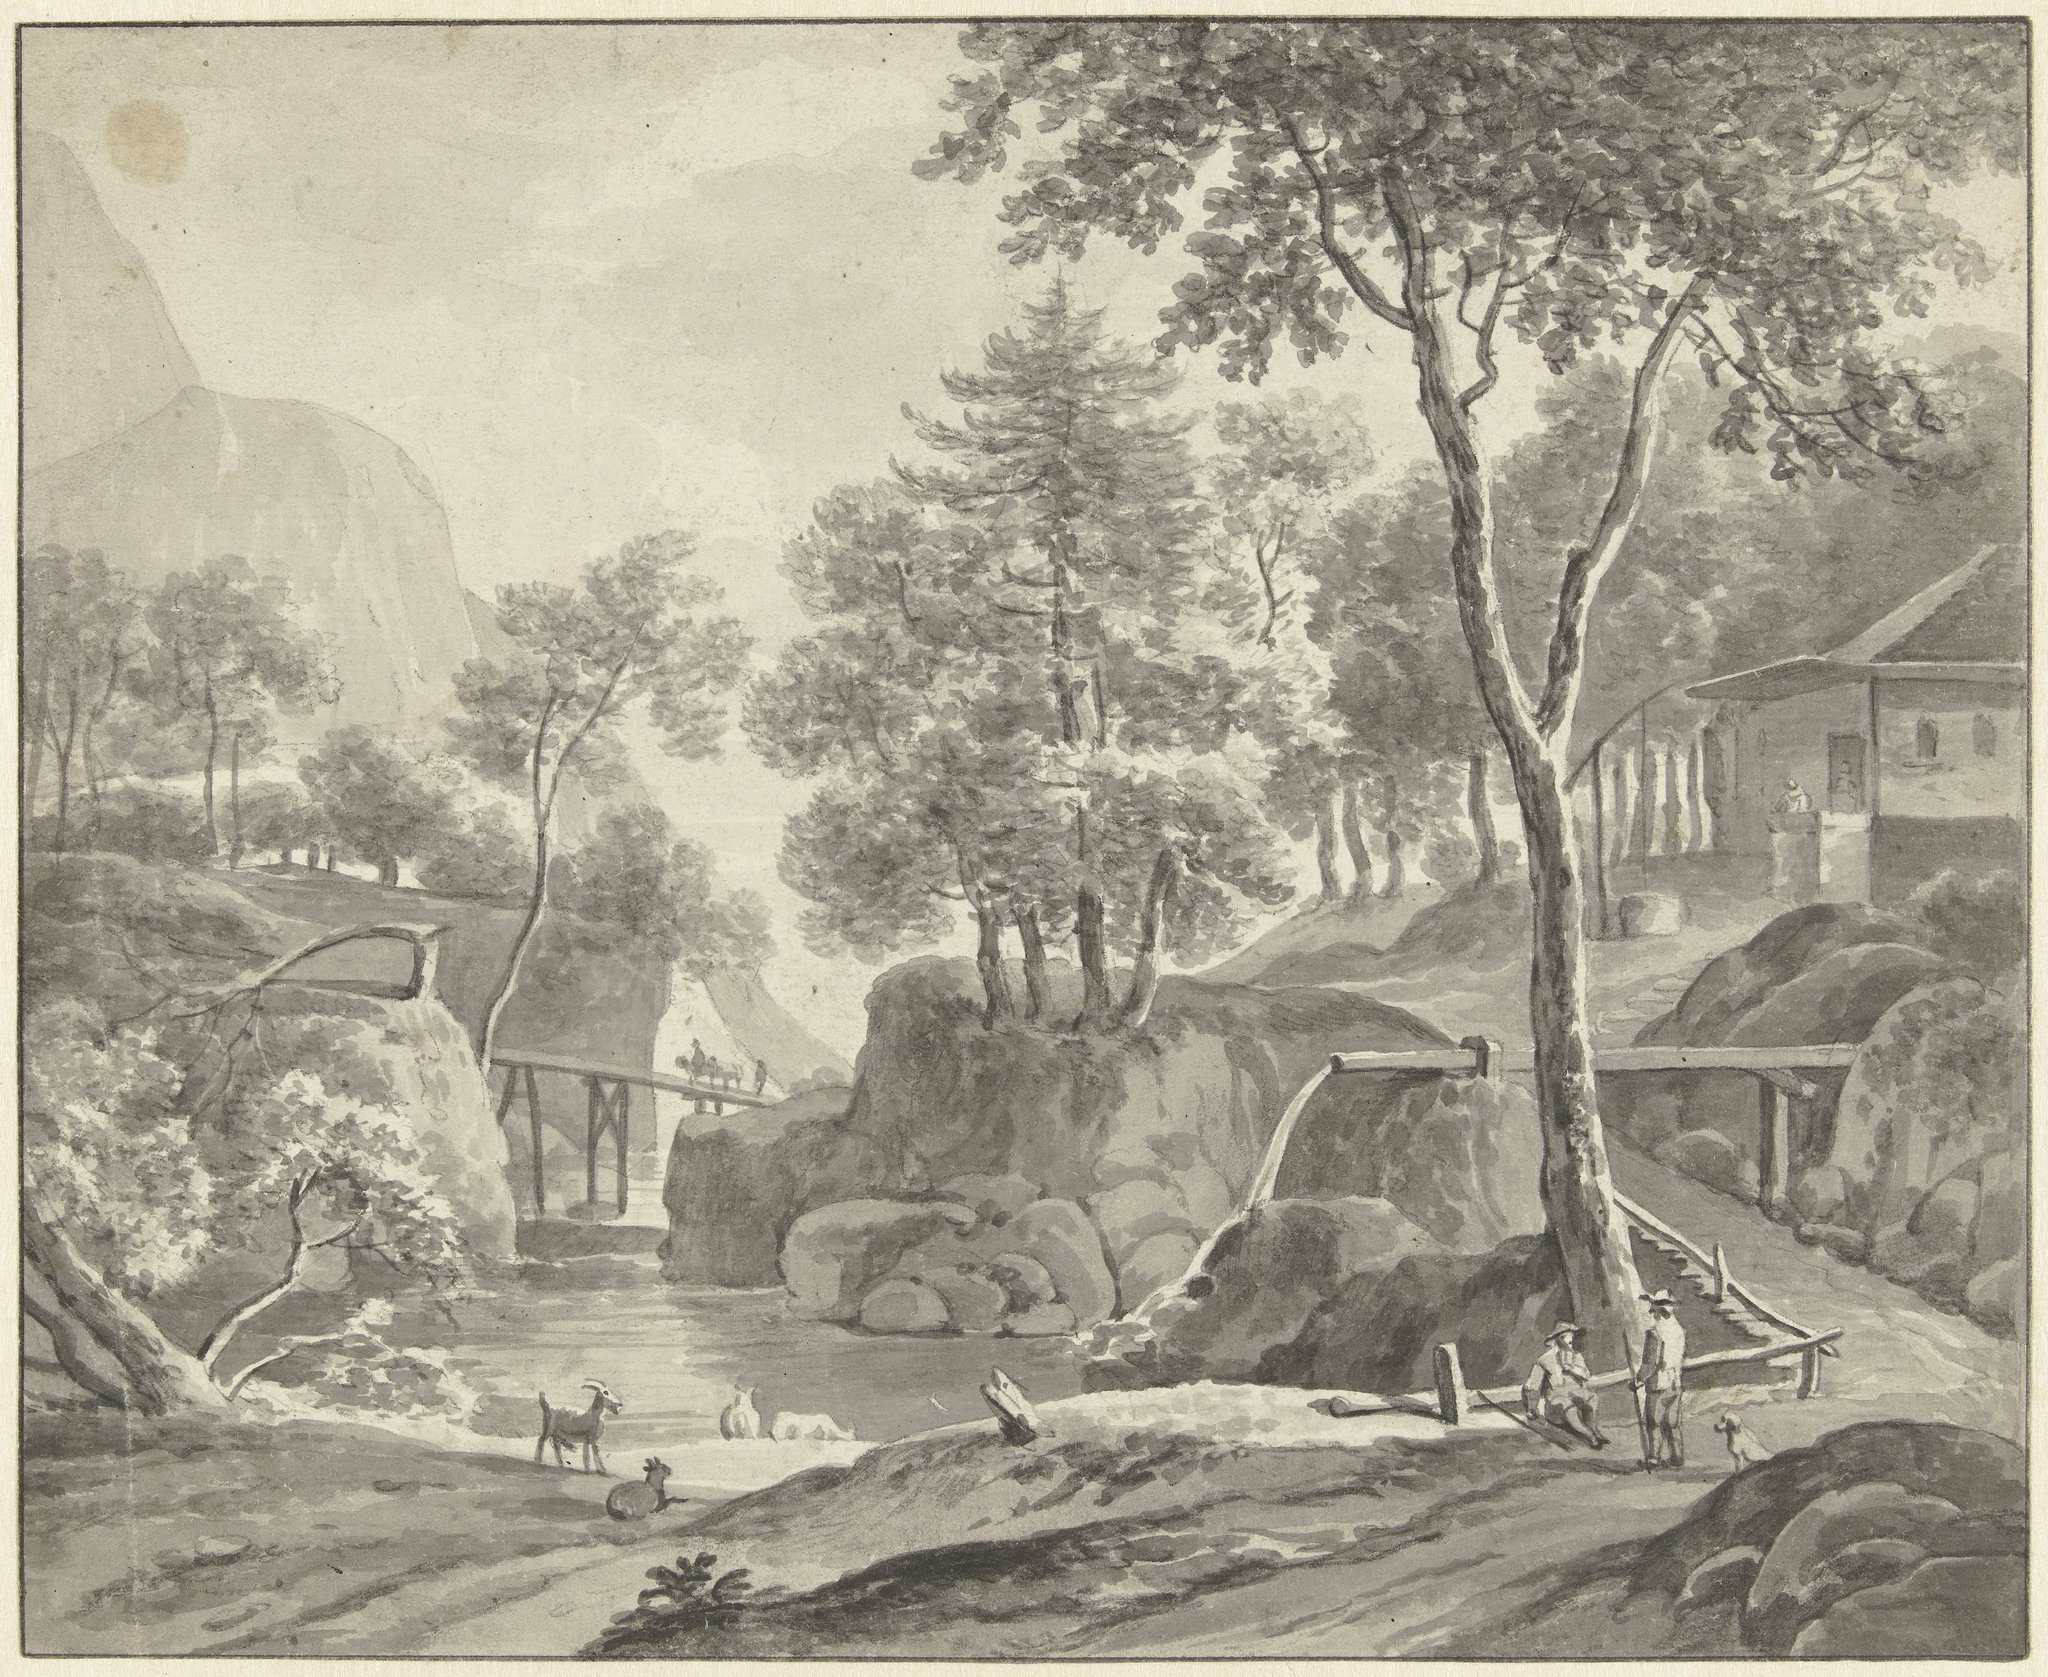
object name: drawing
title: Landschap met rivier, wandelaars en vee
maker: daniël dupré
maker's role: draughtsman, print maker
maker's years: 1751-1817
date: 1786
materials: chalk, paper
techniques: brush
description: Landschap met rivier, rustende wandelaars en vee bij het water.